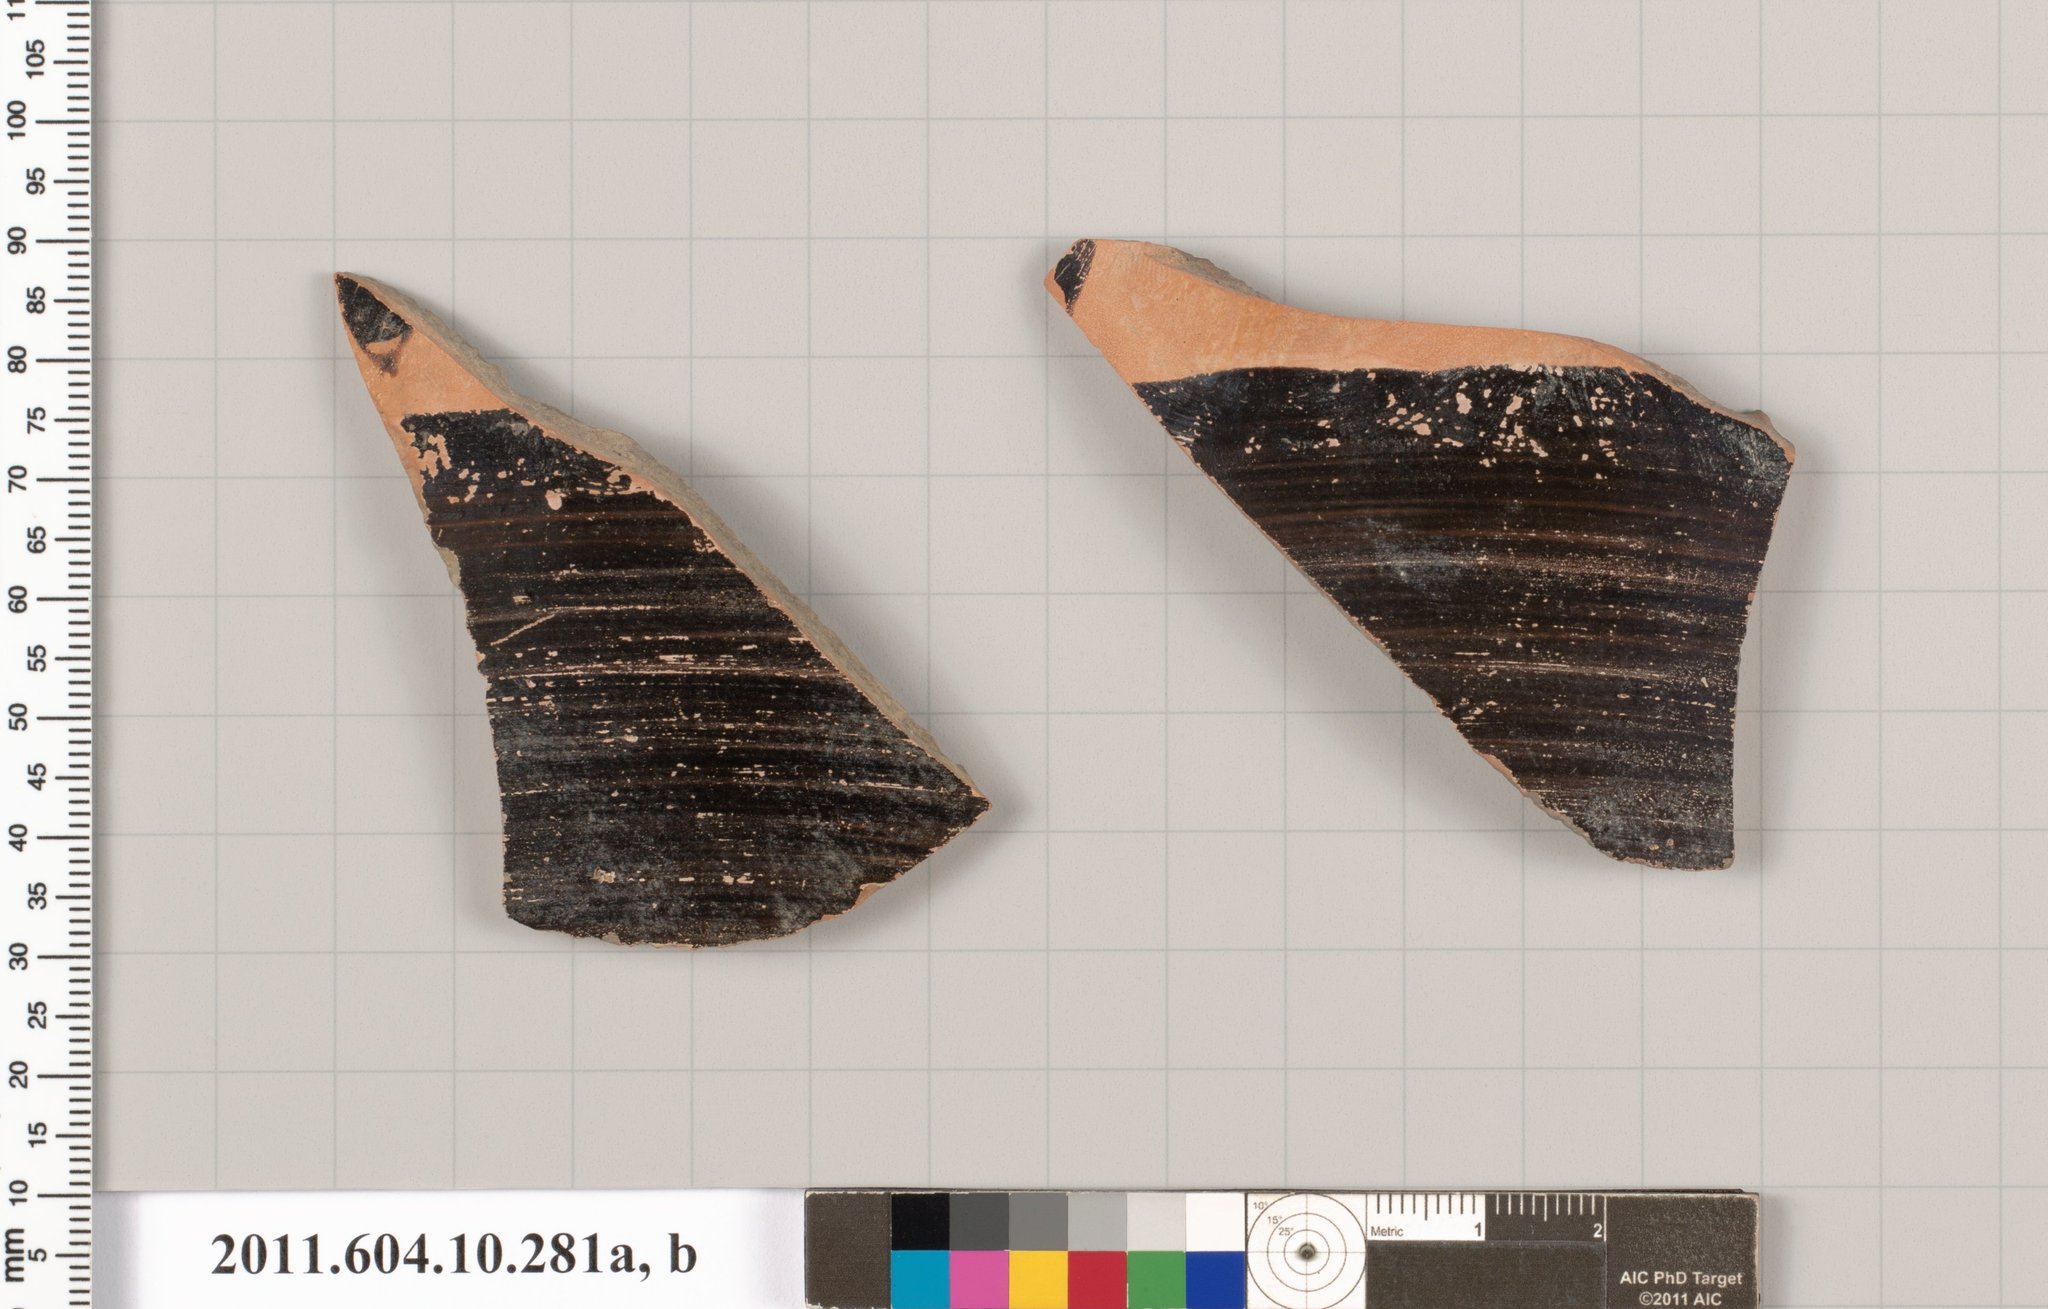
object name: undetermined open shape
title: Terracotta fragments of an open shape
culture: etruscan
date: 534-468 BCE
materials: terracotta